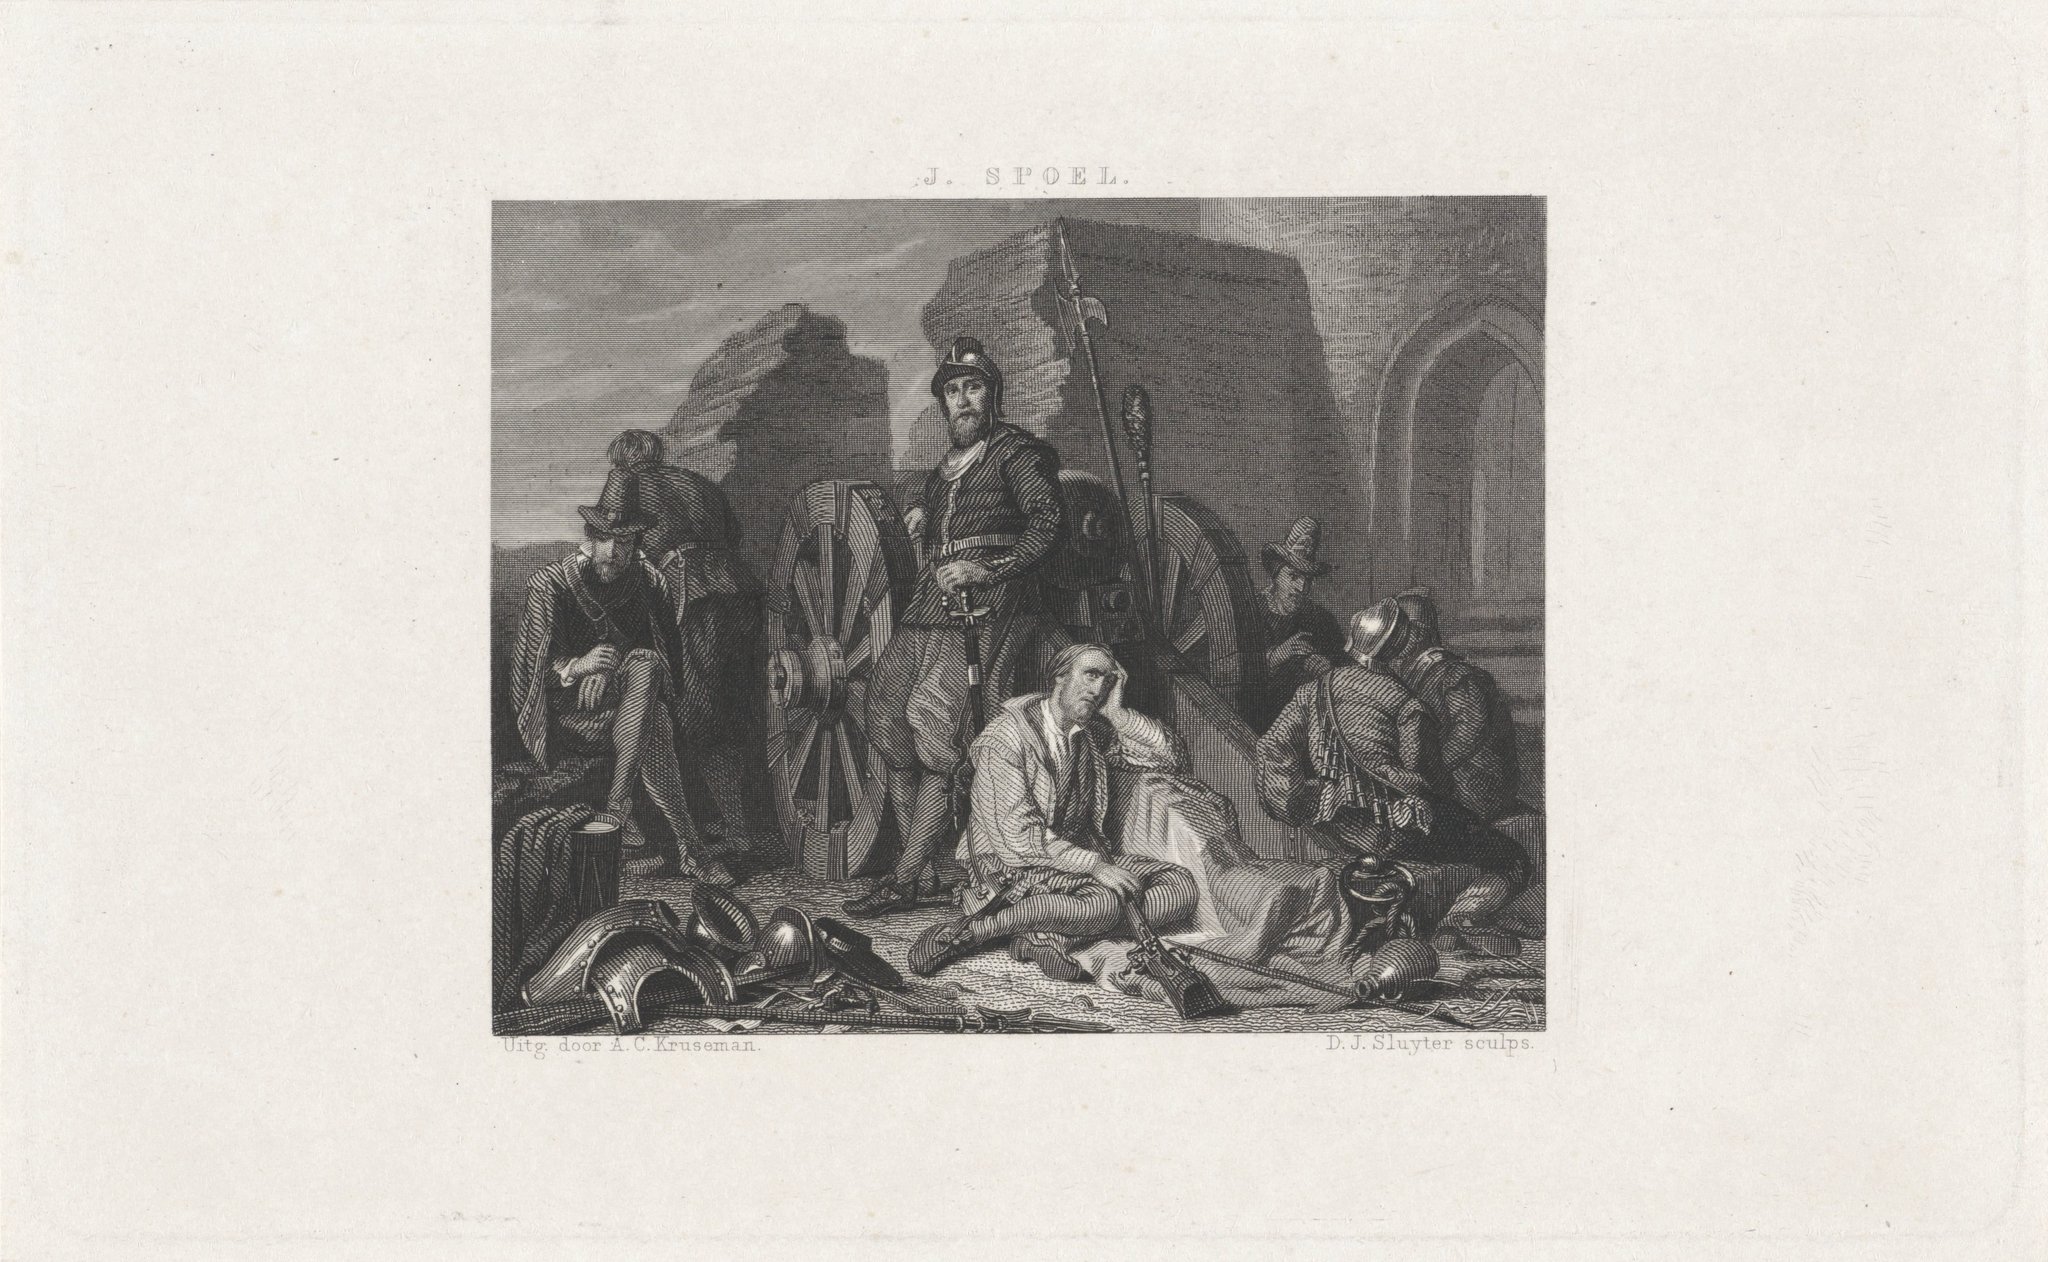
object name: print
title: De vermoeide bezetting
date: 1853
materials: paper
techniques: etching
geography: amsterdam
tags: artillery range, firing range, shooting range ~ military training, after the battle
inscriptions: inscription: ‘Uit Aurora 1853’, collector's mark: Lugt 2228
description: Soldaten rusten uit bij een kanon voor een stukgeschoten muur. Voor het kanon zit een man die de loop van zijn geweer vasthoudt. Op de voorgrond liggen helmen, borstkurassen en wapens. Door de dichter S.J. van den Berg in het Jaarboekje Aurora (1853) geïnterpreteerd als een scène uit het Beleg van Maastricht (1579).